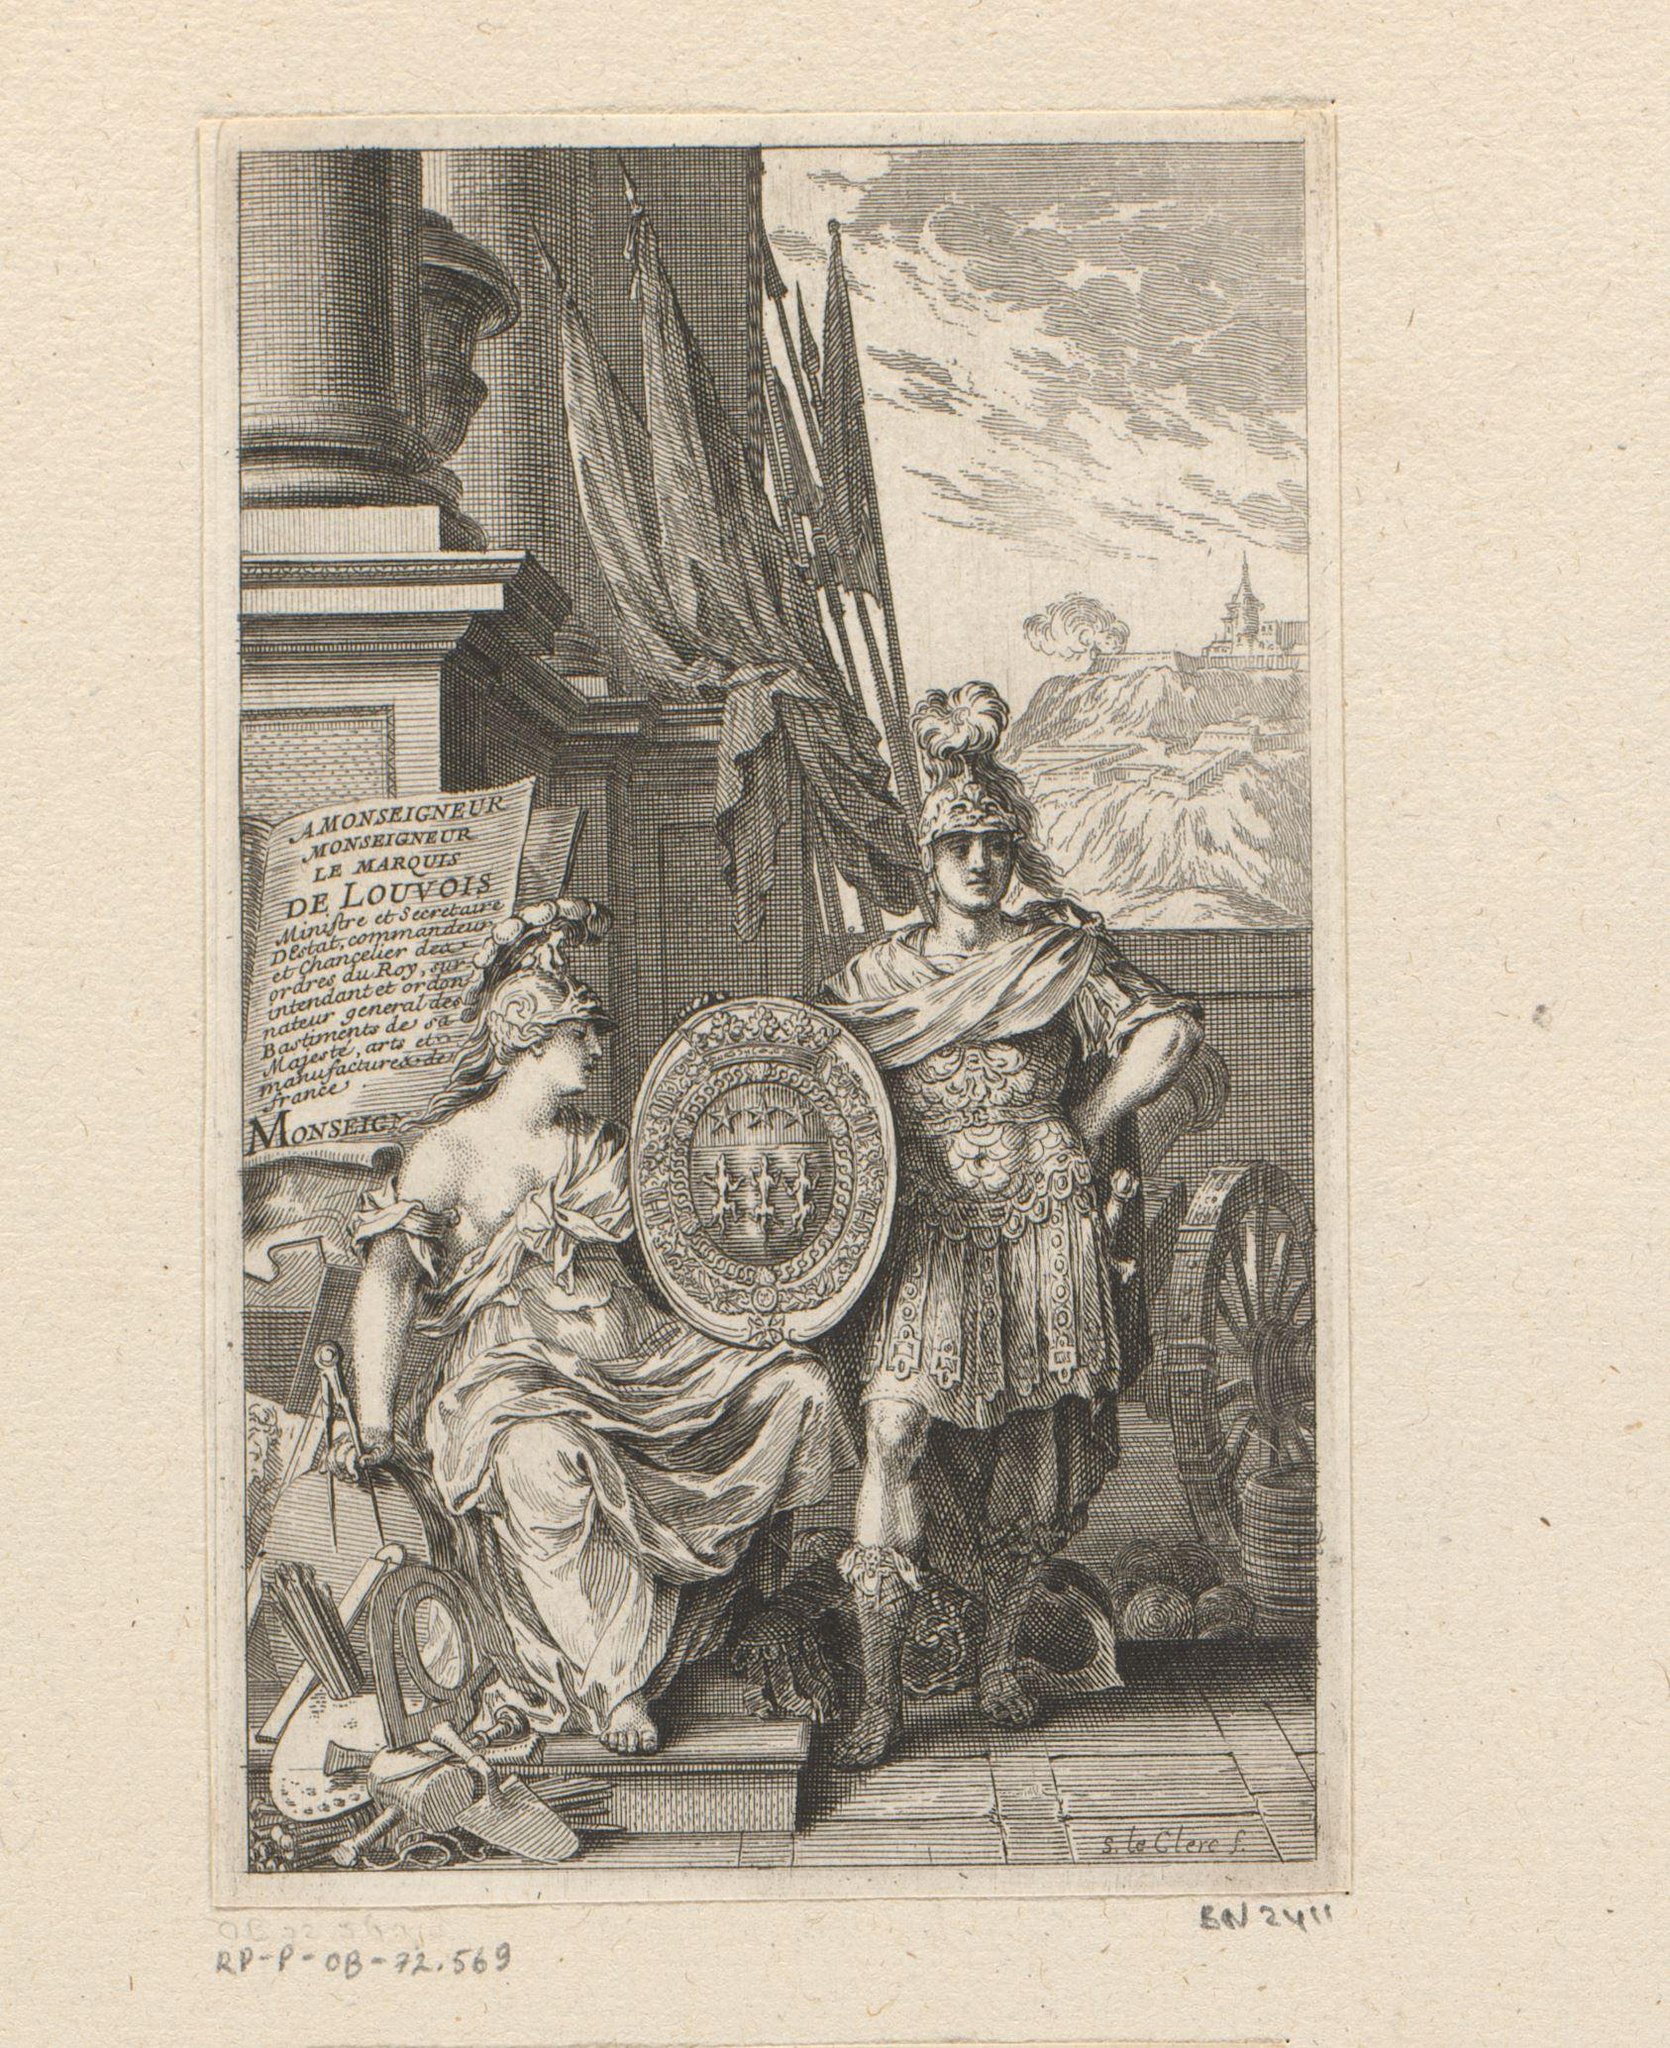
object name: print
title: Titelpagina voor: Sébastien Leclerc, Traité de géométrie (...), 1690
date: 1690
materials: paper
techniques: engraving, etching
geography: france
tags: (story of) mars (ares), 'geometria' (~ quadrivium); 'geometria' (ripa)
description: Prent uit: Leclerc, Sébastien. Traité de géométrie (...). Parijs: Jean Jombert, 1690.